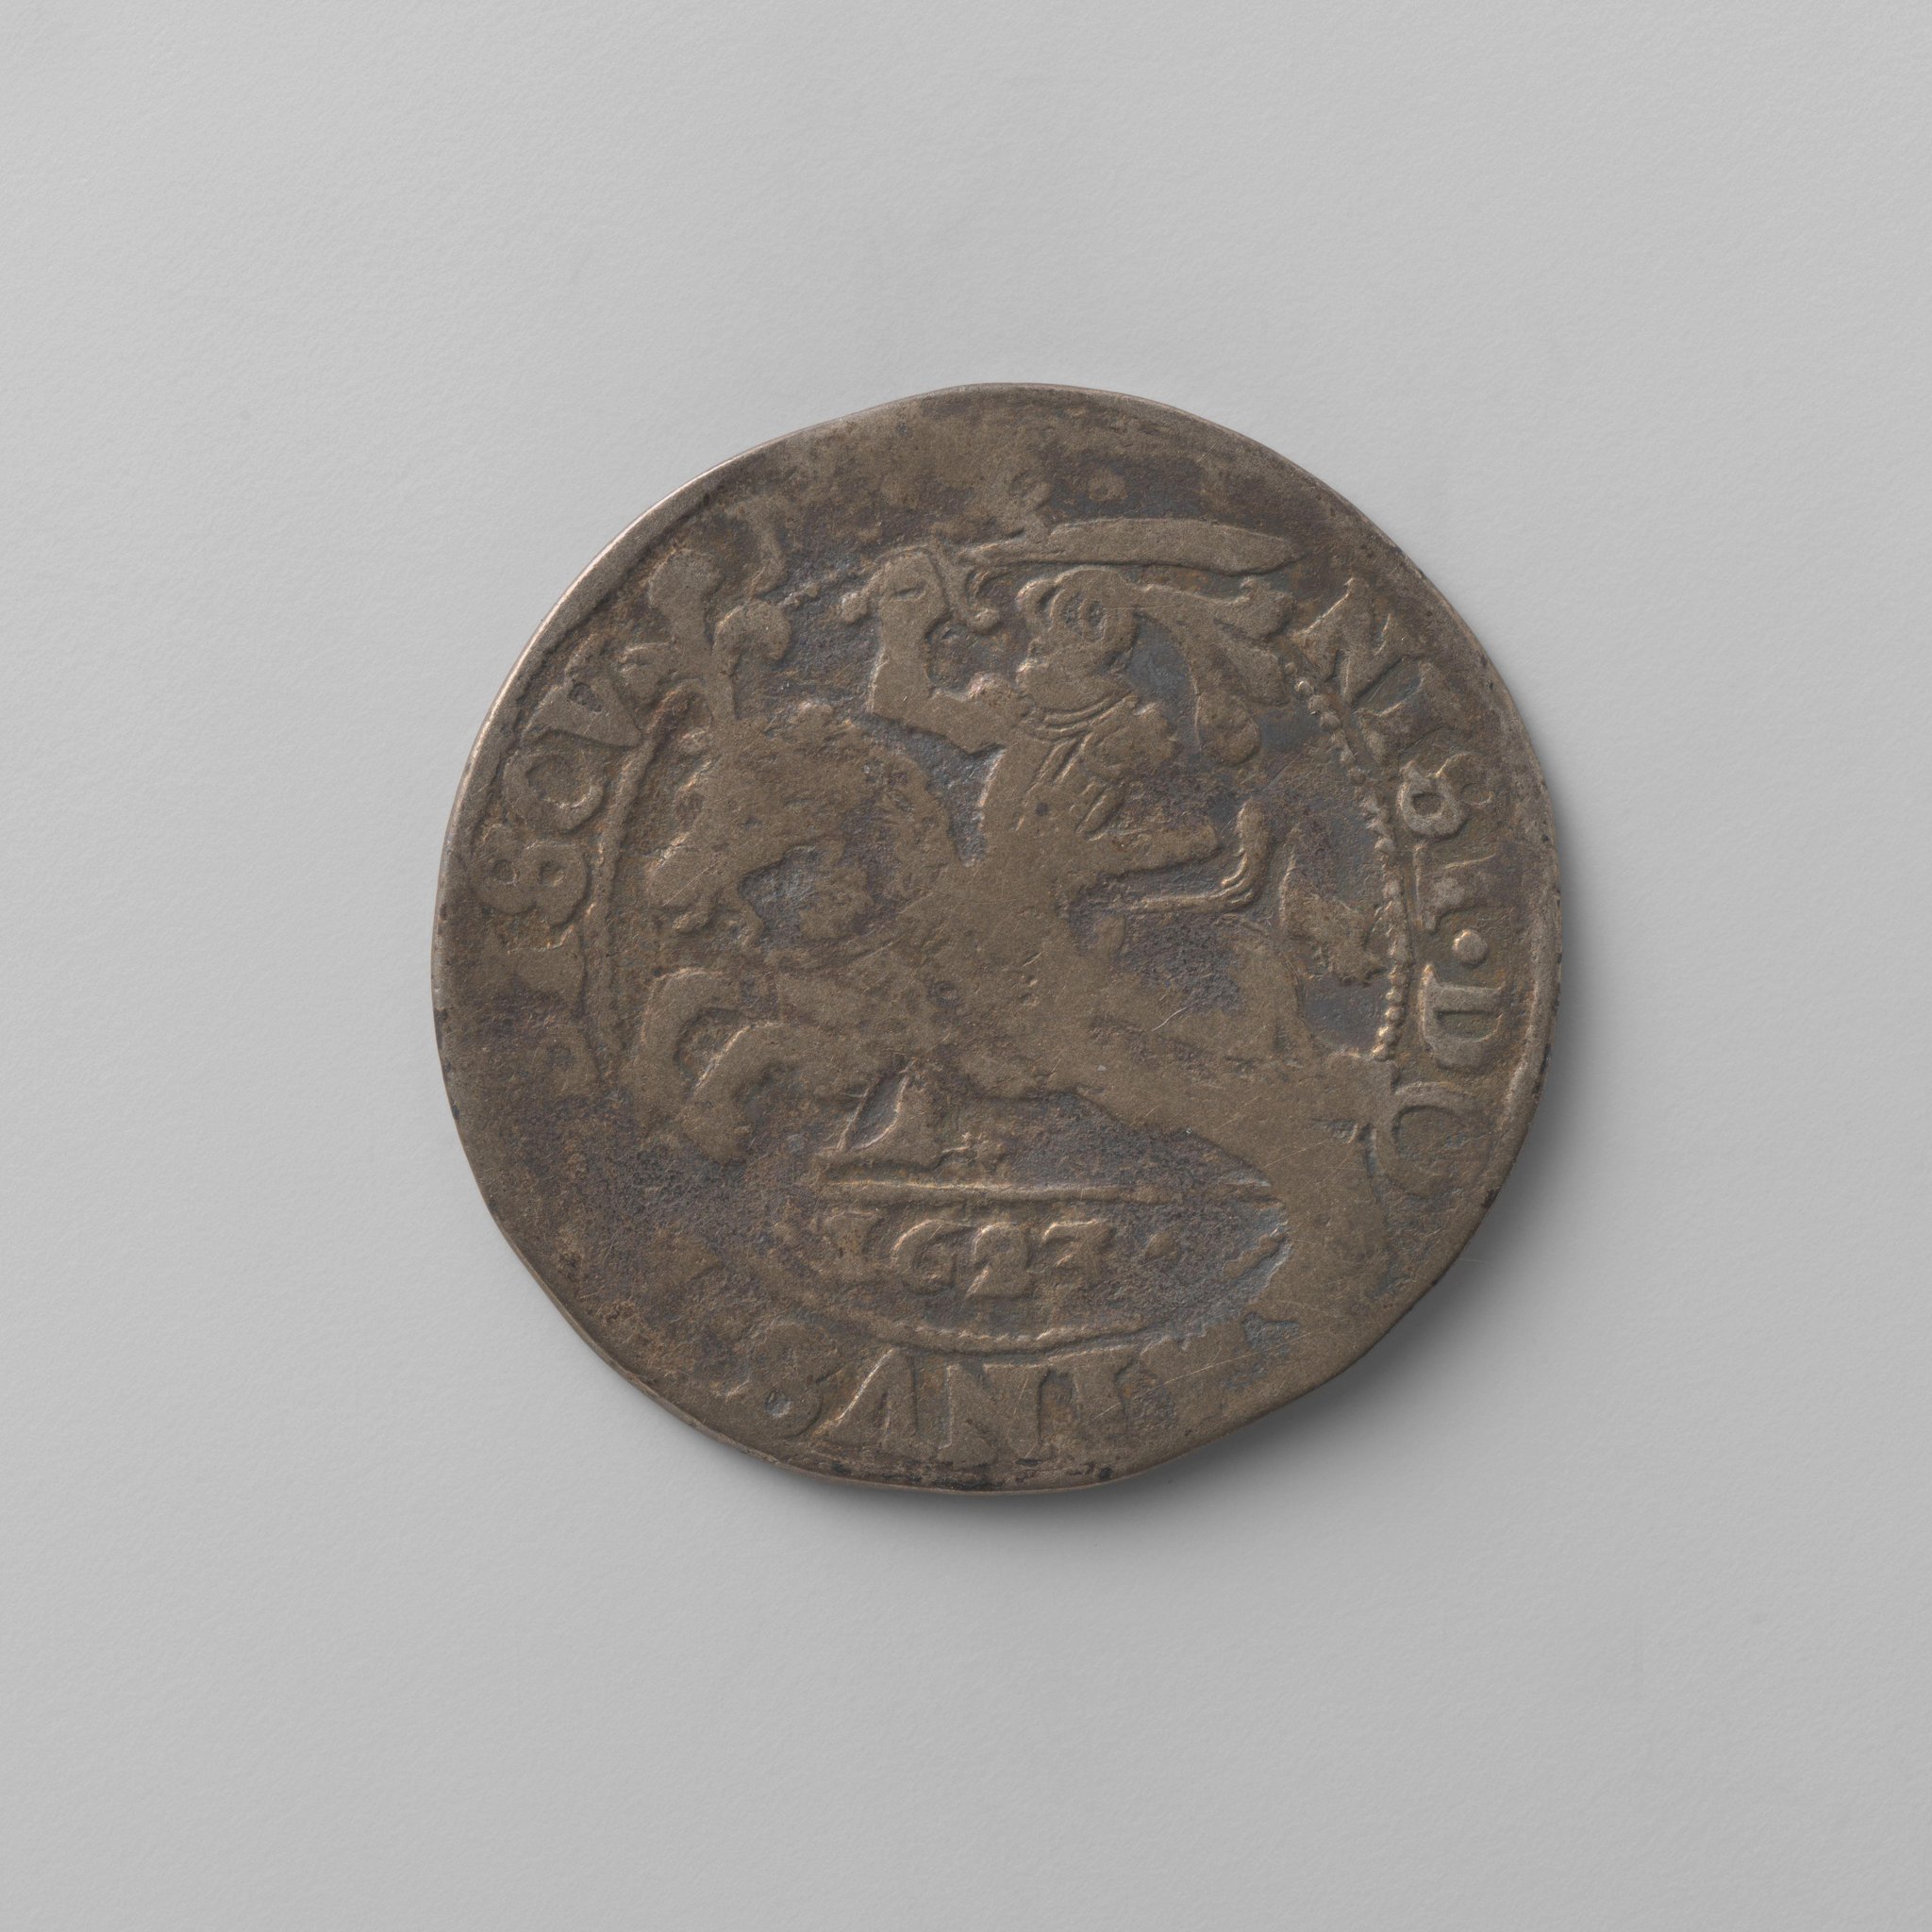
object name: coin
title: Snaphaanschelling van Friesland, 1623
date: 1623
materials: silver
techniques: striking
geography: leeuwarden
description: Zilveren munt. Voorzijde: ridder te paard naar links met in rechterhand zwaard. In afsnede jaartal. Keerzijde: op lang gebloemd kruis ongekroond wapenschild van Friesland.